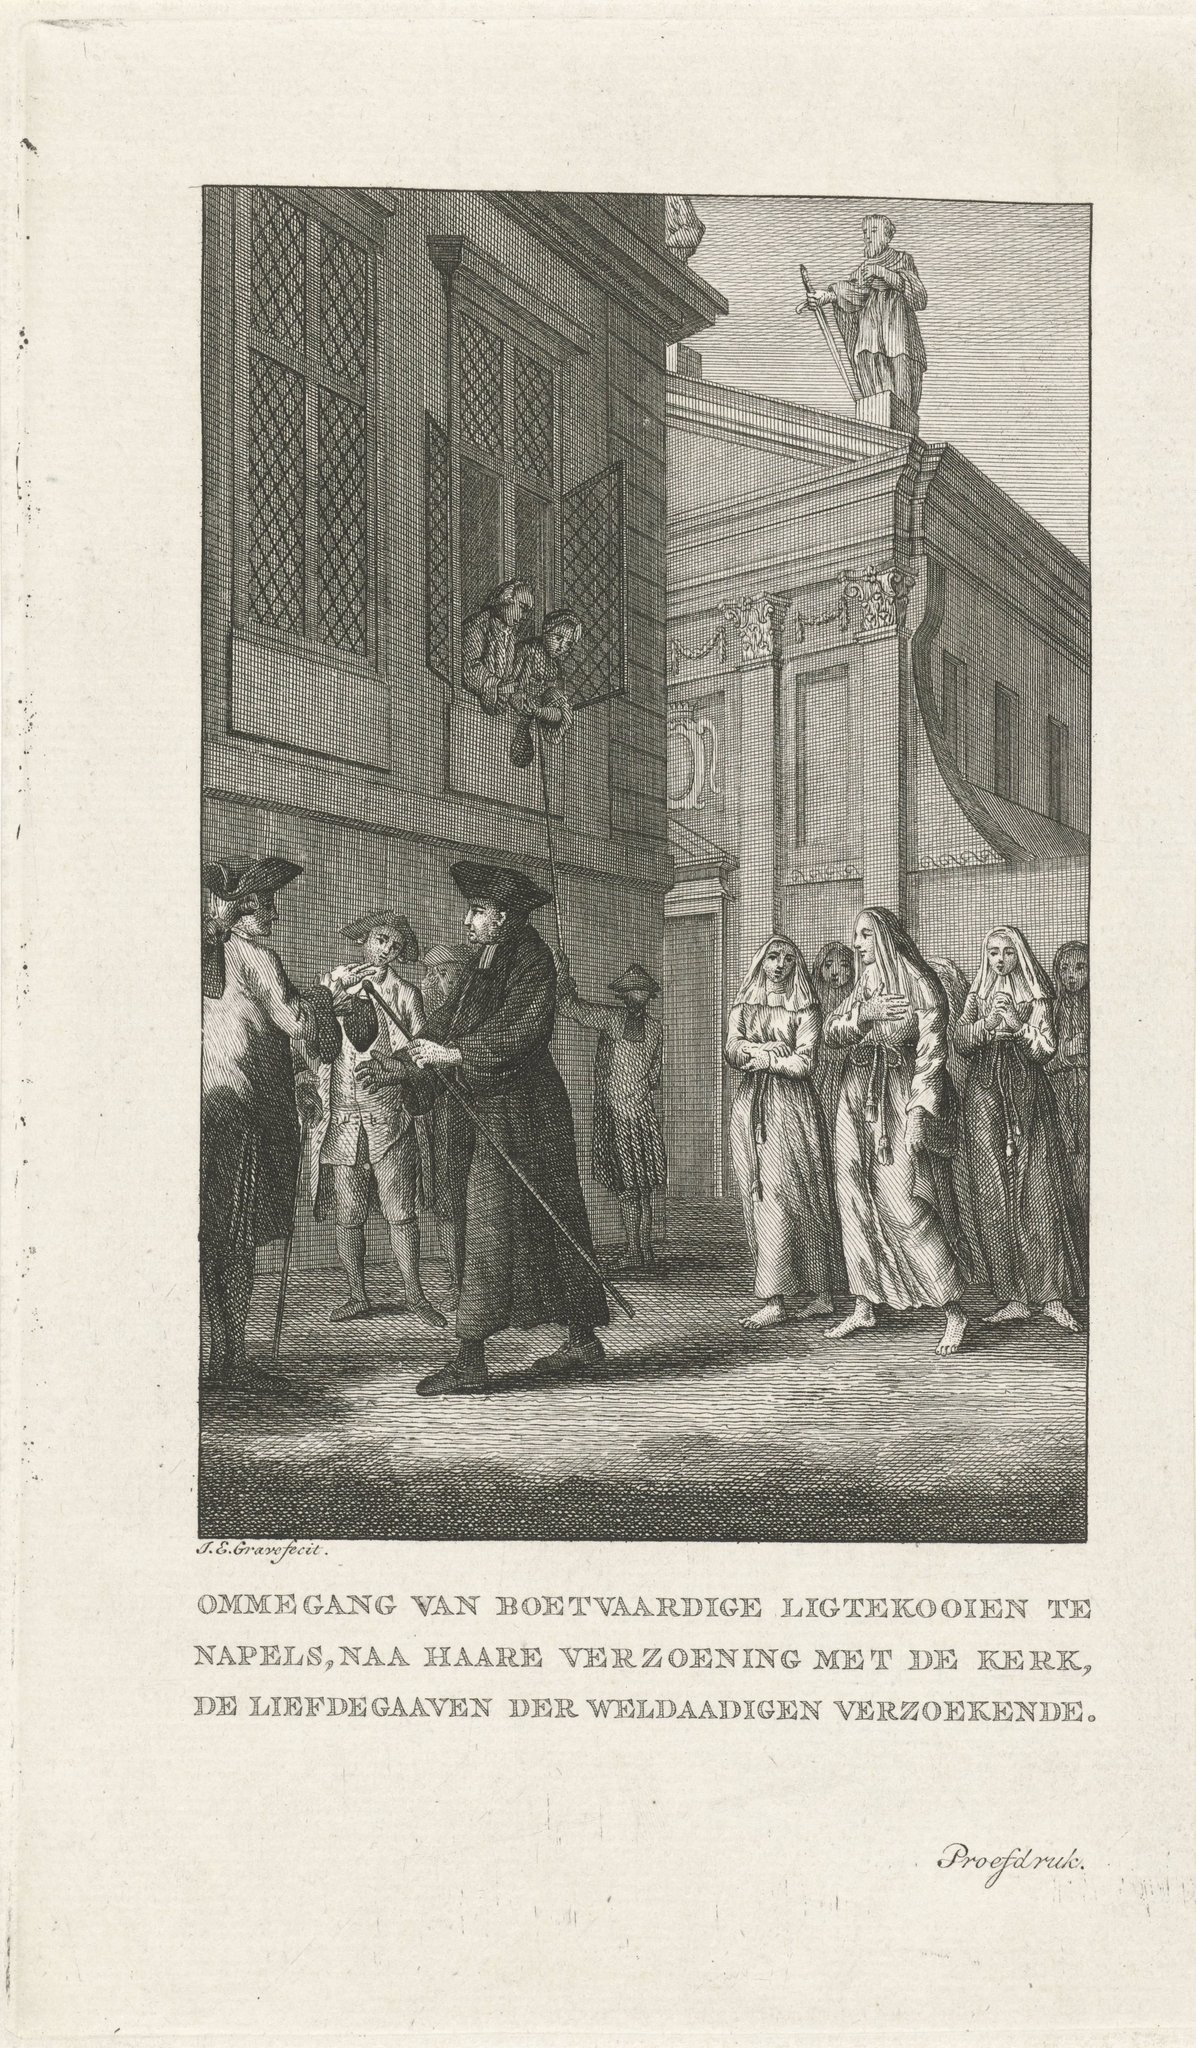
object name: print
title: Processie van de boetvaardige prostituees te Napels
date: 1769-1805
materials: paper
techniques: engraving, etching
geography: amsterdam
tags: whore, prostitute, procession ~ christian religion, charitable works, public penance, general avowal of faults, naples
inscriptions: collector's mark: Lugt 2228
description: Een processie van boetvaardige prostituees te Napels. Voorop gaat een priester met een bedelnap, gevolgd door enkele berouwvolle prostituees in een wit boetekleed. Er worden aalmoezen aangenomen van toeschouwers naast de weg. De prent heeft een Nederlands onderschrift.